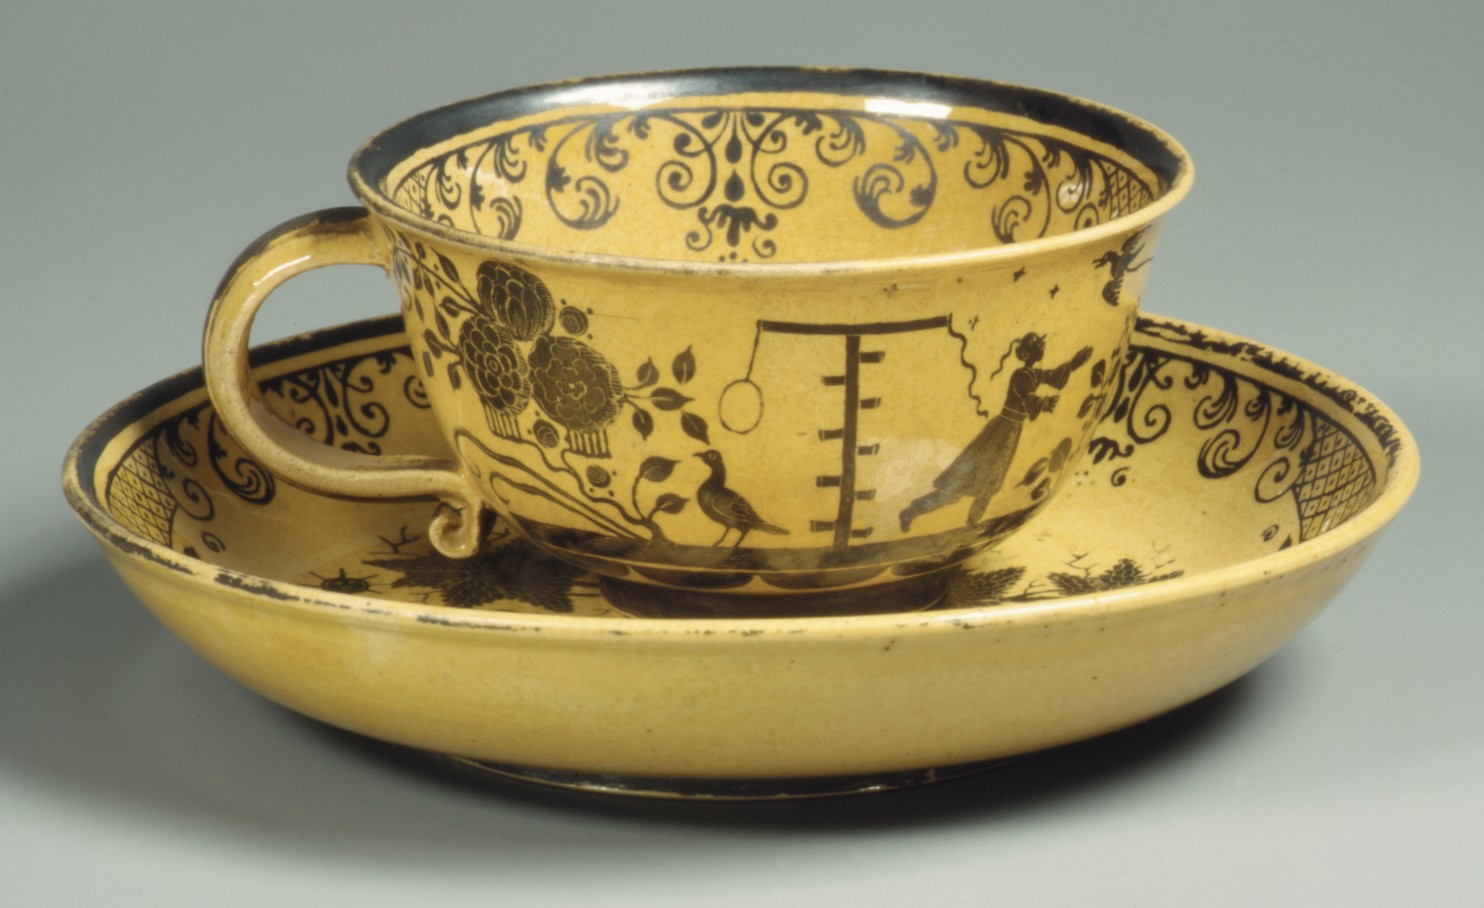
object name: cup and saucer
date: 1730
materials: earthenware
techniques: silvered, glazing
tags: human figures,birds,dogs